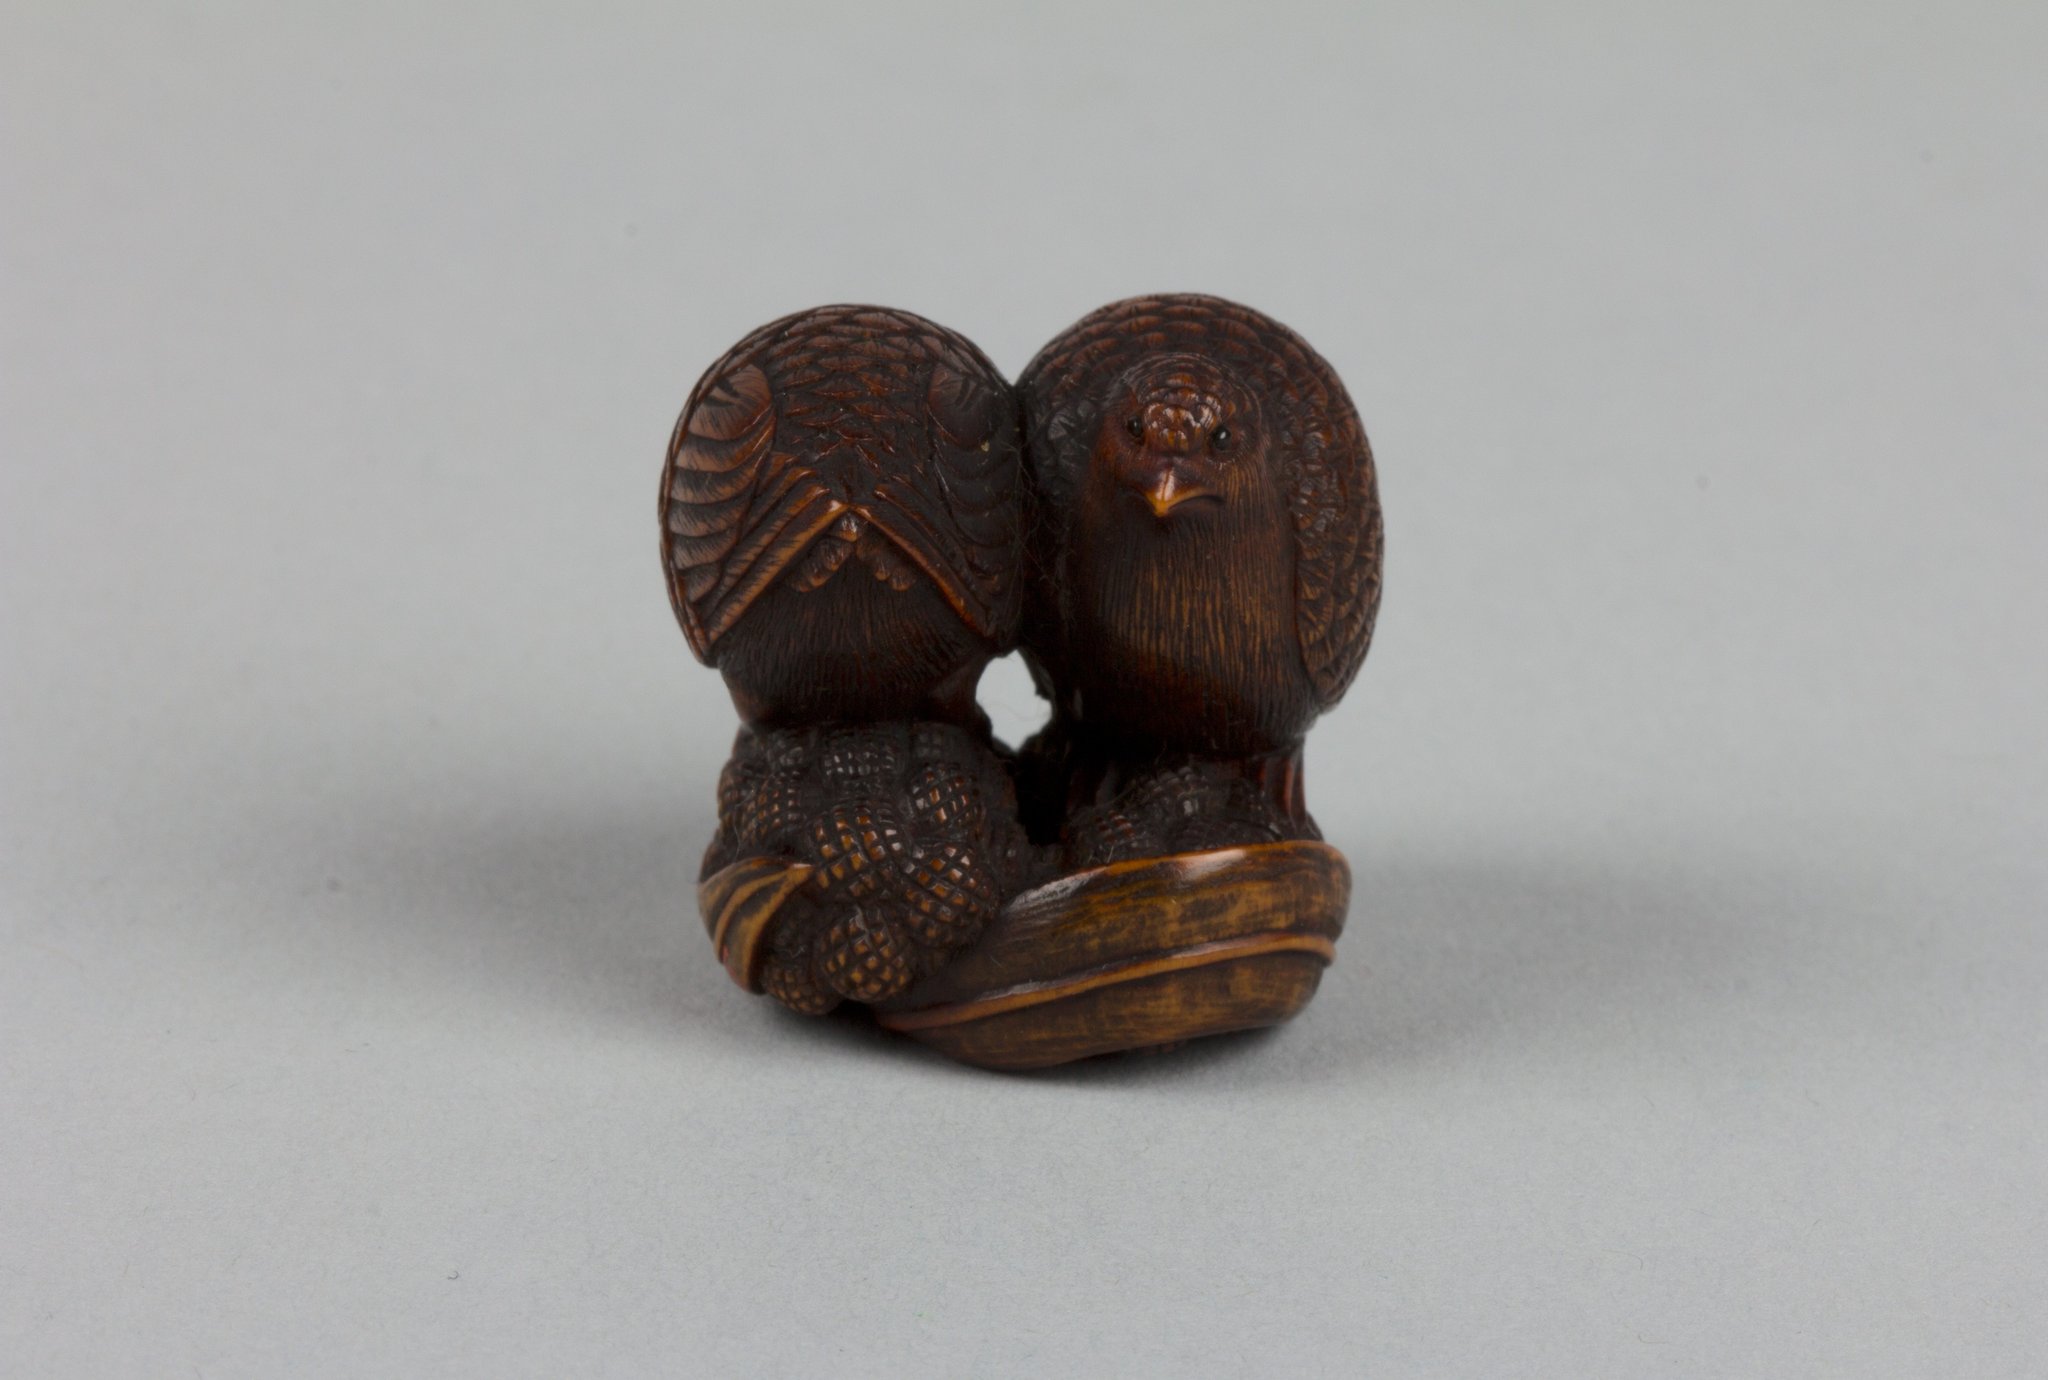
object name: netsuke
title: Netsuke of Quail with Millet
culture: japanese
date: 1801-1900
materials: wood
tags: birds